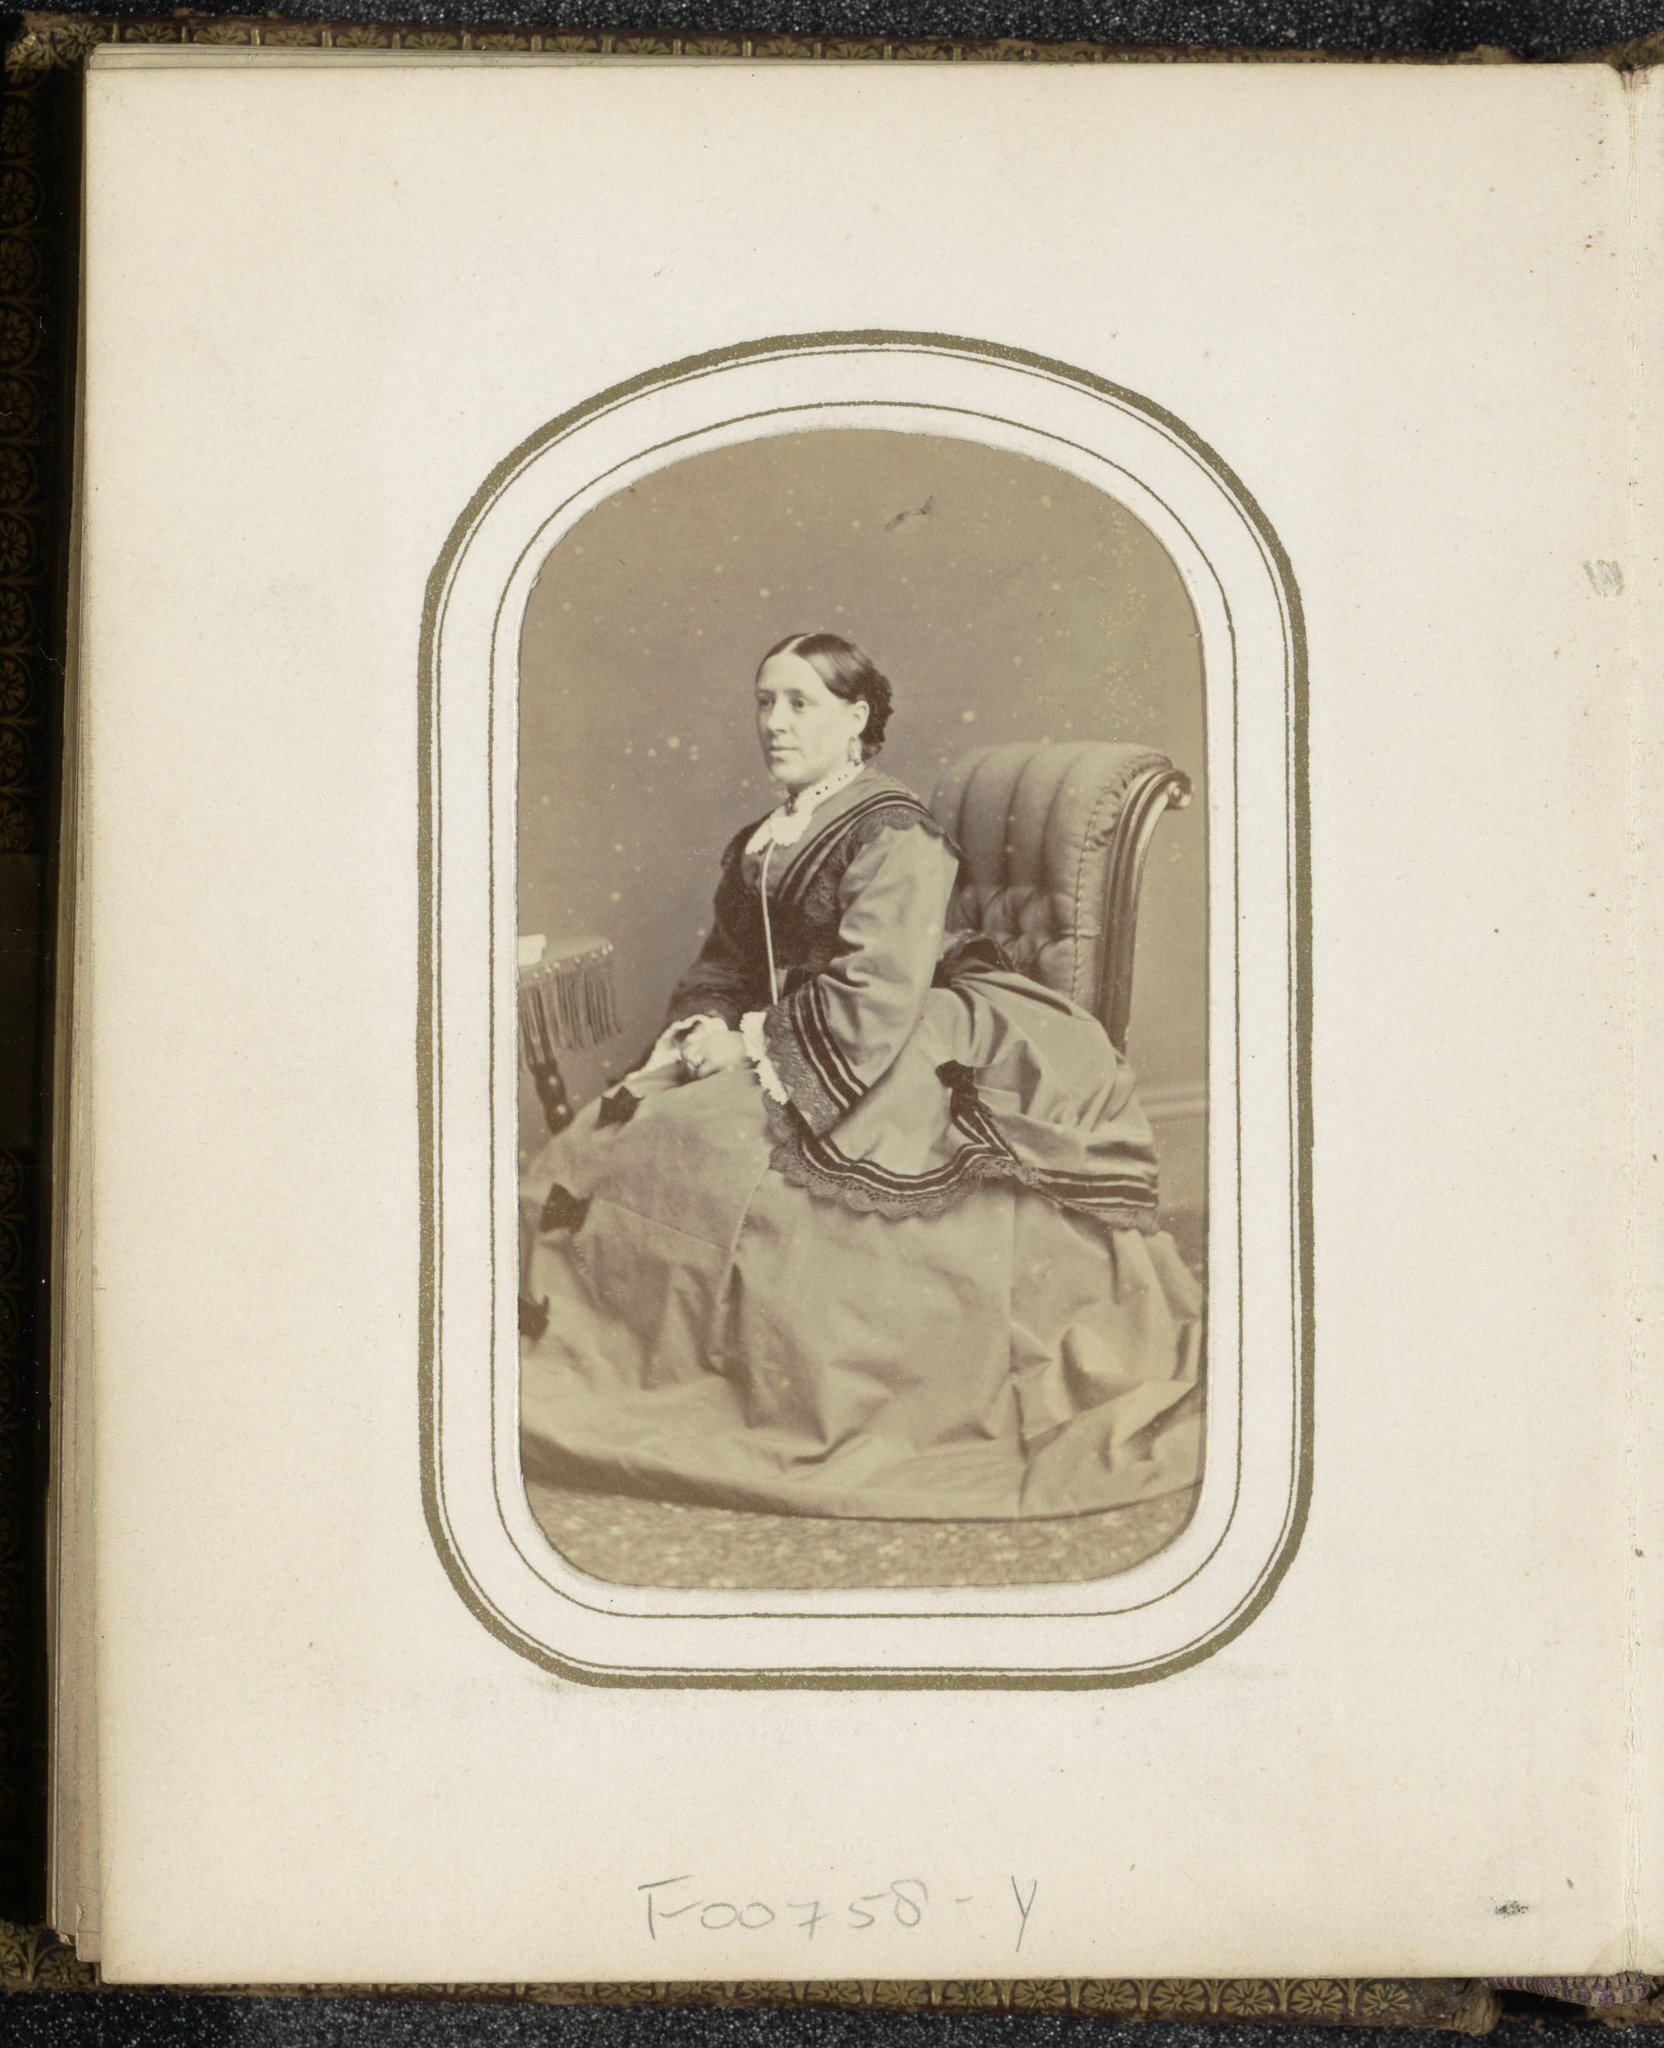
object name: carte de visite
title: Portret van een vrouw met een jasje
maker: joseph higby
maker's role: fotograaf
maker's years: 1834-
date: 1860-1875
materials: cardboard, paper, photographic support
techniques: albumen print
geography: colchester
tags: studio requisites ~ photographer, clothing for the lower part of the body, historical persons, clothing for the upper part of the body, book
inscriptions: address: ‘Colchester, 3 Chapel Street’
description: Onderdeel van Engels fotoalbum van E.A. Kettle met 42 cartes-de-visite.